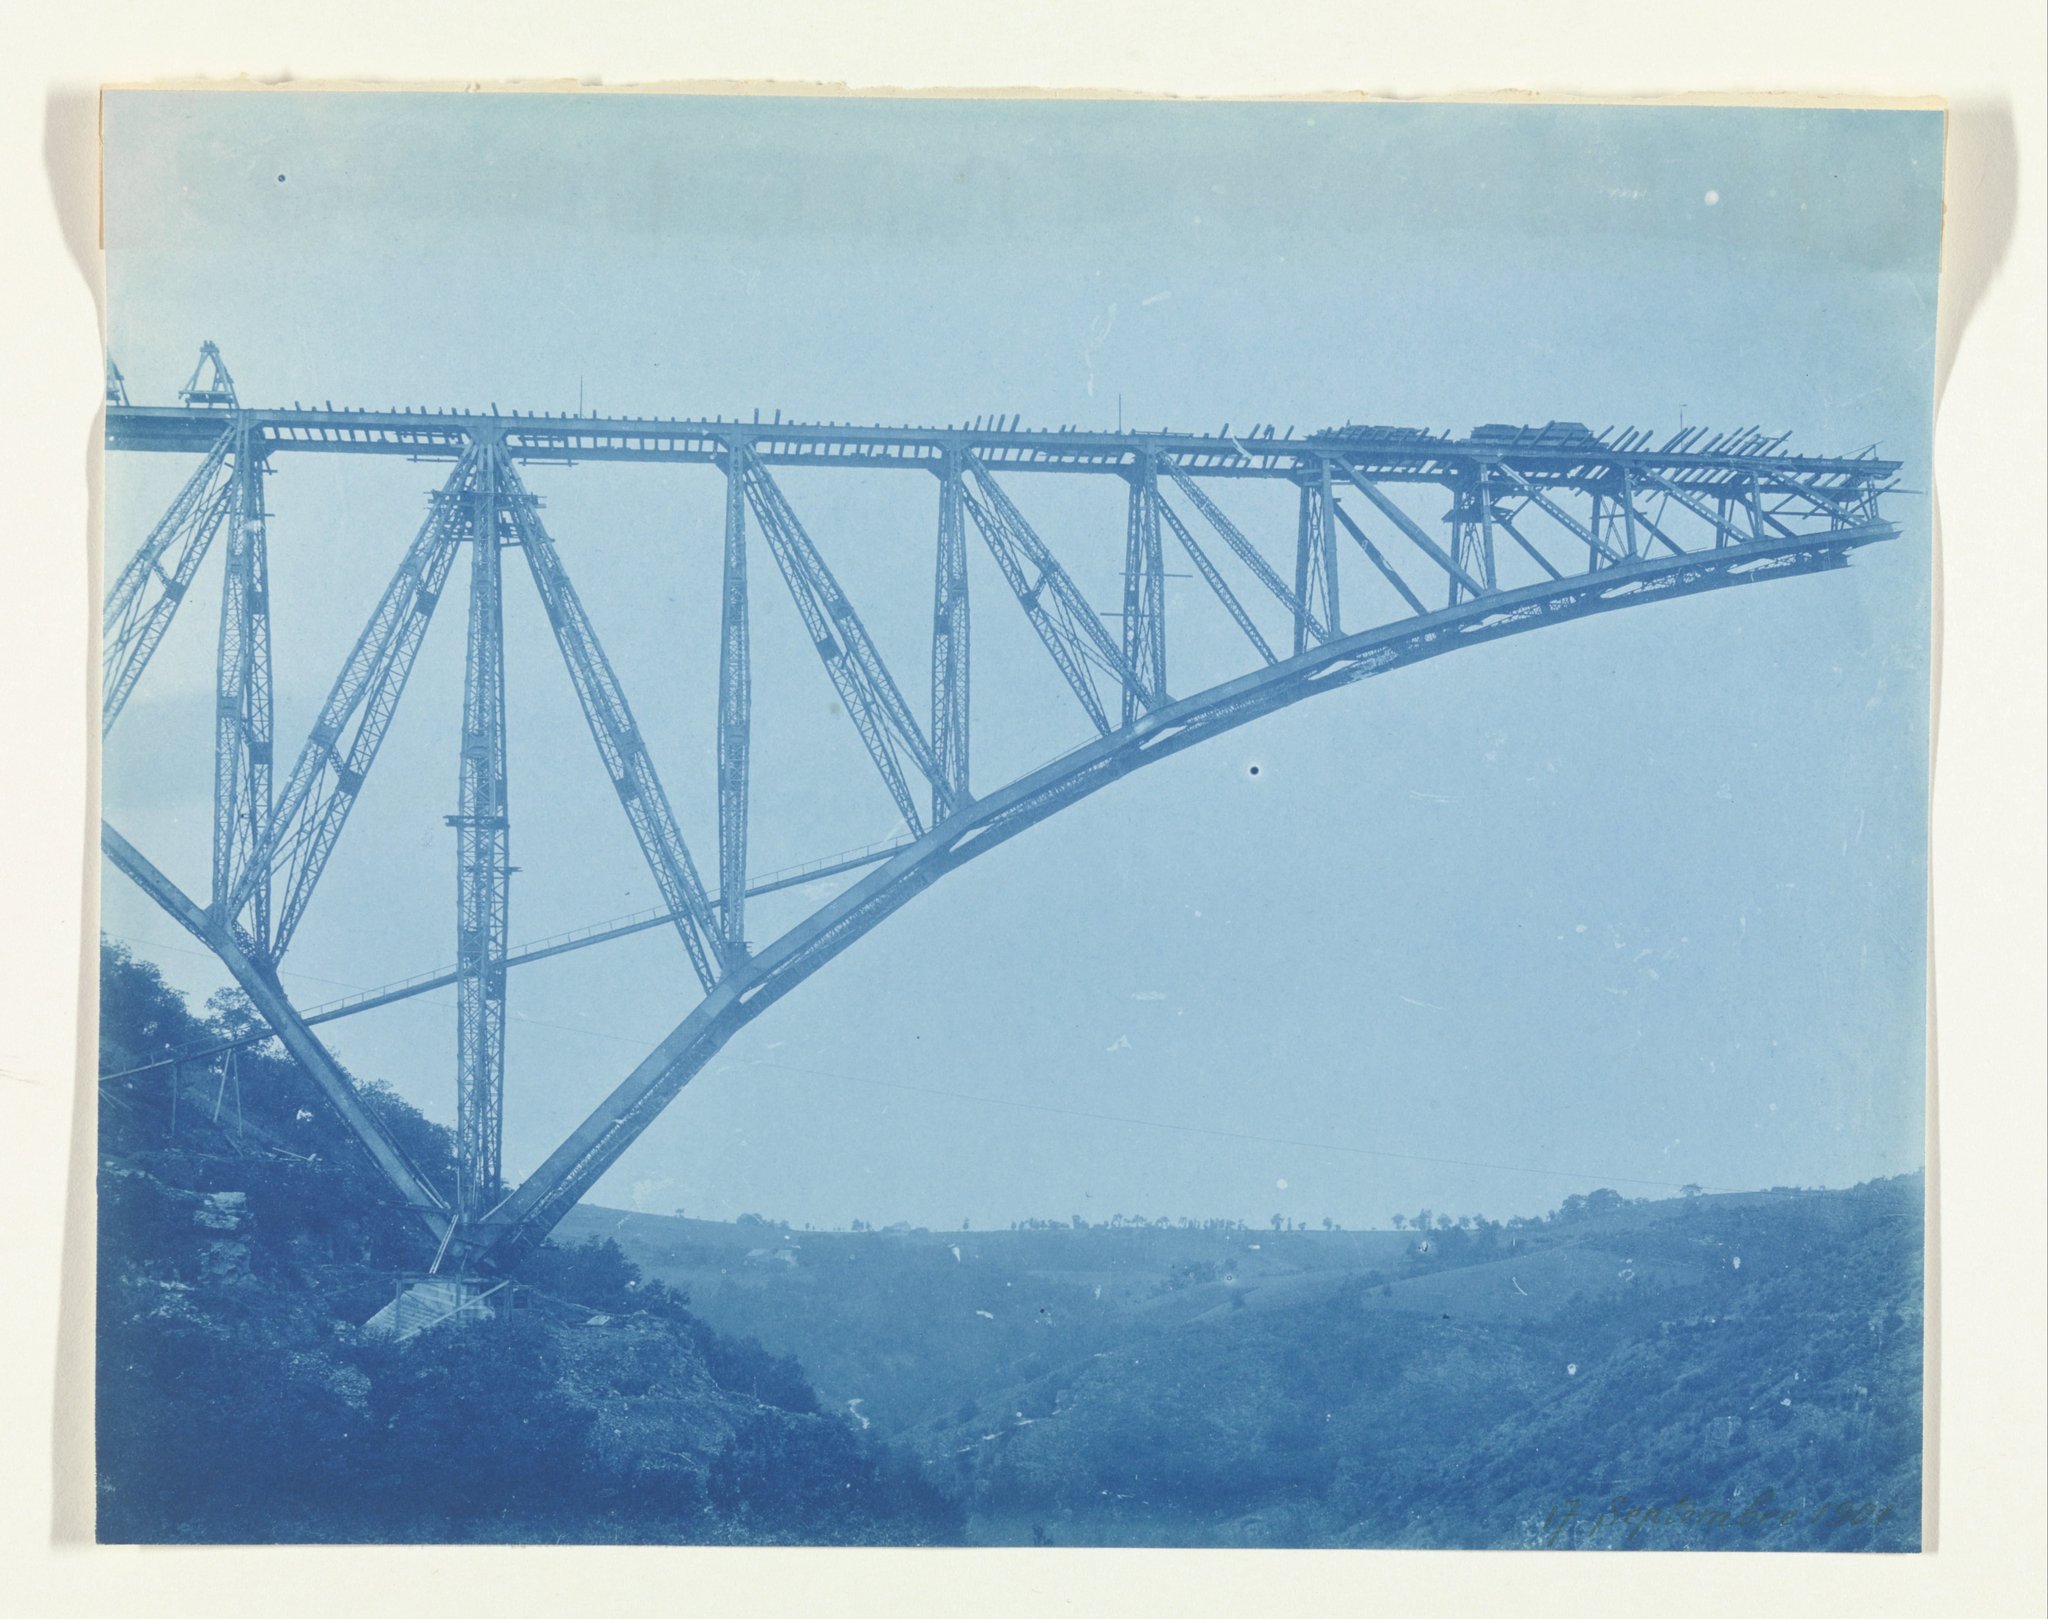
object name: photograph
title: Aanleg van het Viaur Viaduct in Frankrijk door de Societé de Construction des Battignolles, 17 september 1901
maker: Anonymous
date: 1901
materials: photographic support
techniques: cyanotype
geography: france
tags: viaduct, making the overground structures (~ building activities)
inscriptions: date